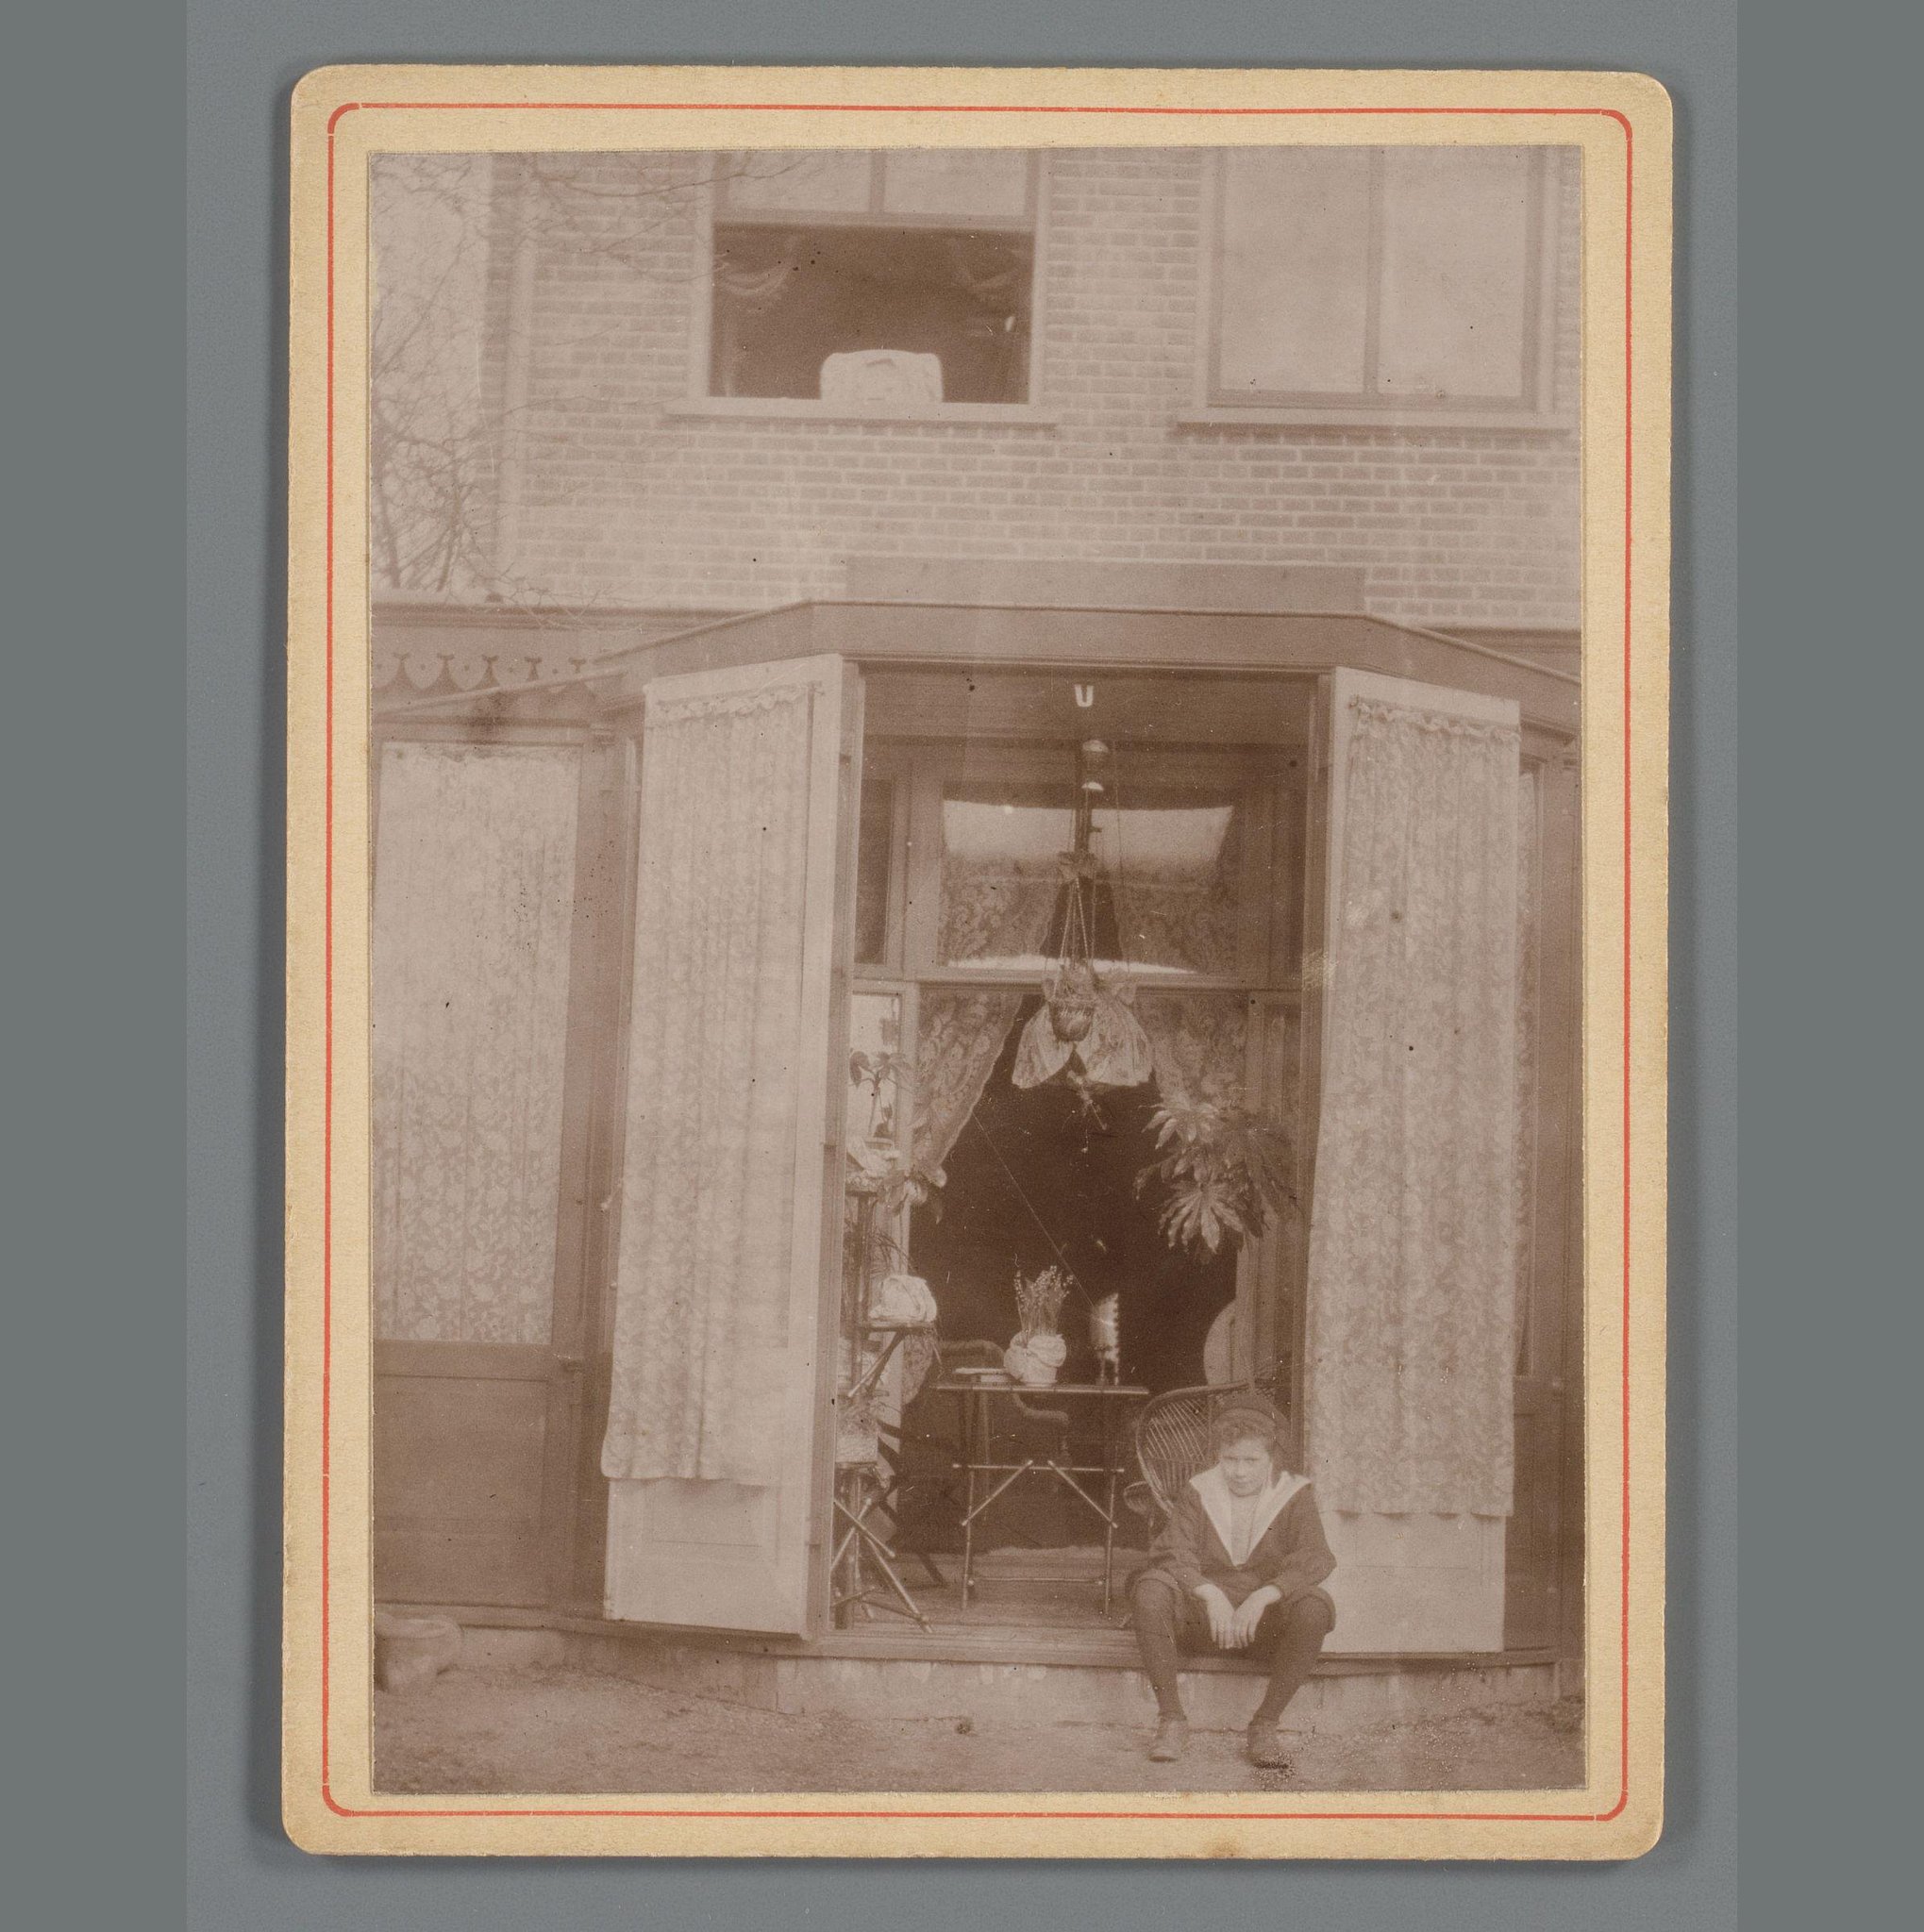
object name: cabinet photograph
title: Ewoud (Dick) Vreede zittend op de deurpost van het huis van zijn oom Willem de Jong in Leiden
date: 1900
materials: paper, cardboard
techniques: collodion silver print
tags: the hague, ewoud adrianus vreede (dick), boy (child between toddler and youth), historical persons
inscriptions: address: ‘Noordeinde 46/ Leiden’, inscription: ‘(Dick Vreede)’